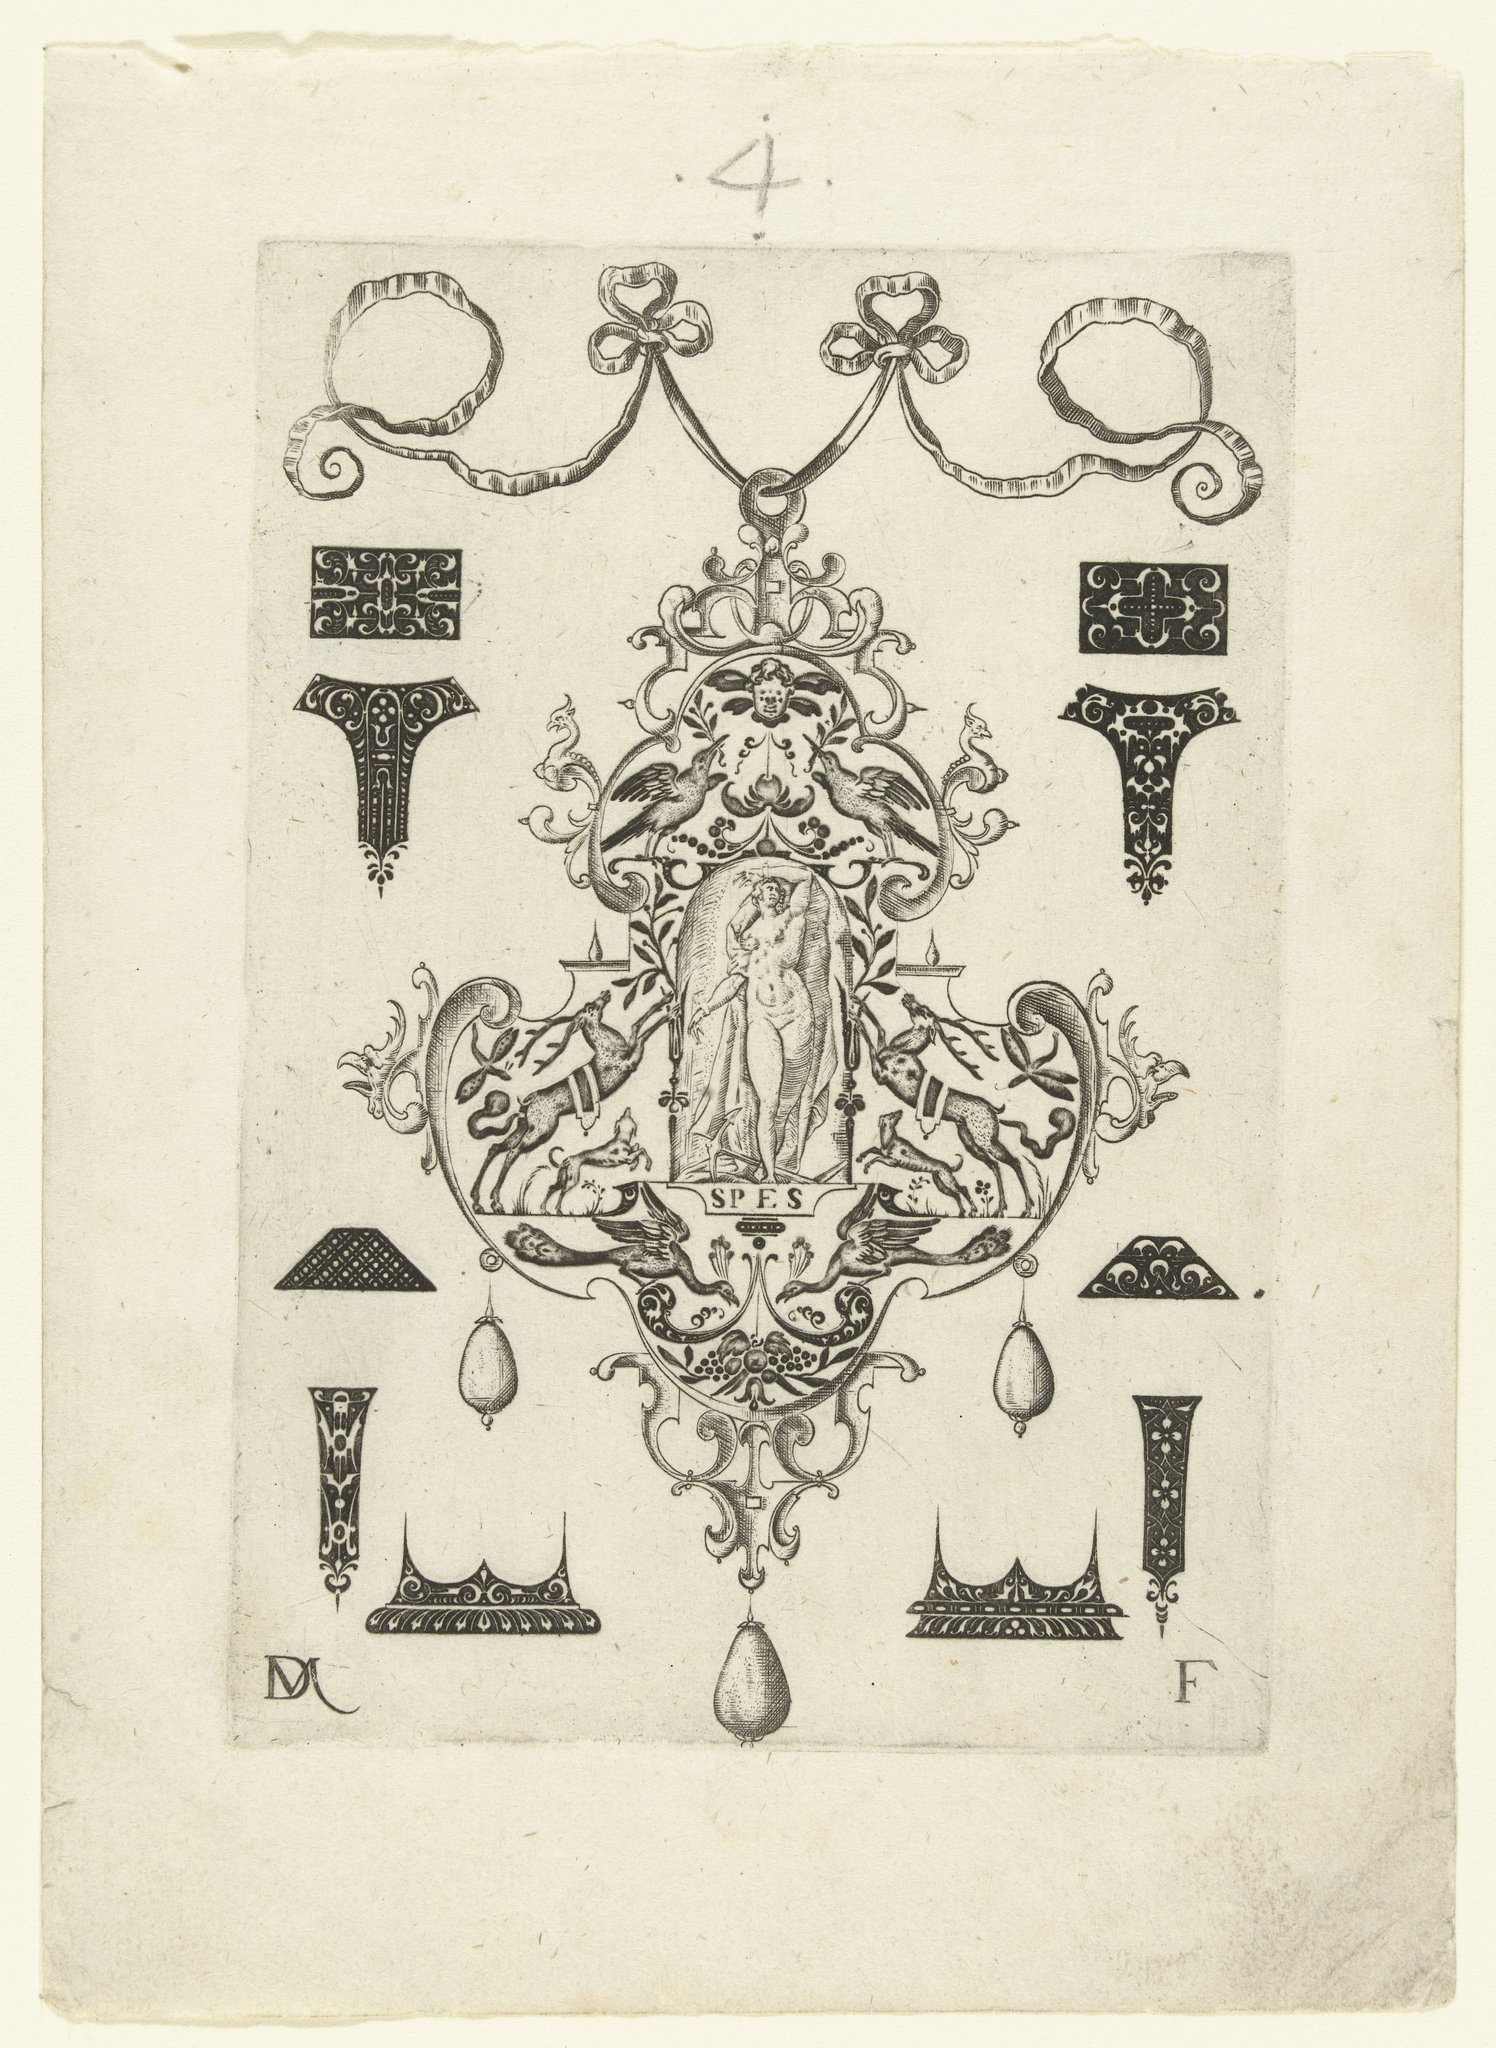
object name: ornament print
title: Spes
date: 1593-1616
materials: paper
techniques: engraving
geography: germany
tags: hope, 'spes'; 'speranza divina e certa' (ripa) ~ one of the three theological virtues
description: Spes in een omlijsting van krulwerk met twee vogels, twee herten, twee honden en twee pauwen. Blad uit serie van hangers met deugden, bestaande uit een titelblad en 7 bladen. Aan elke hanger hangen drie parels. Om de hangers heen zijn kleine kostuumsieraden weergegeven.